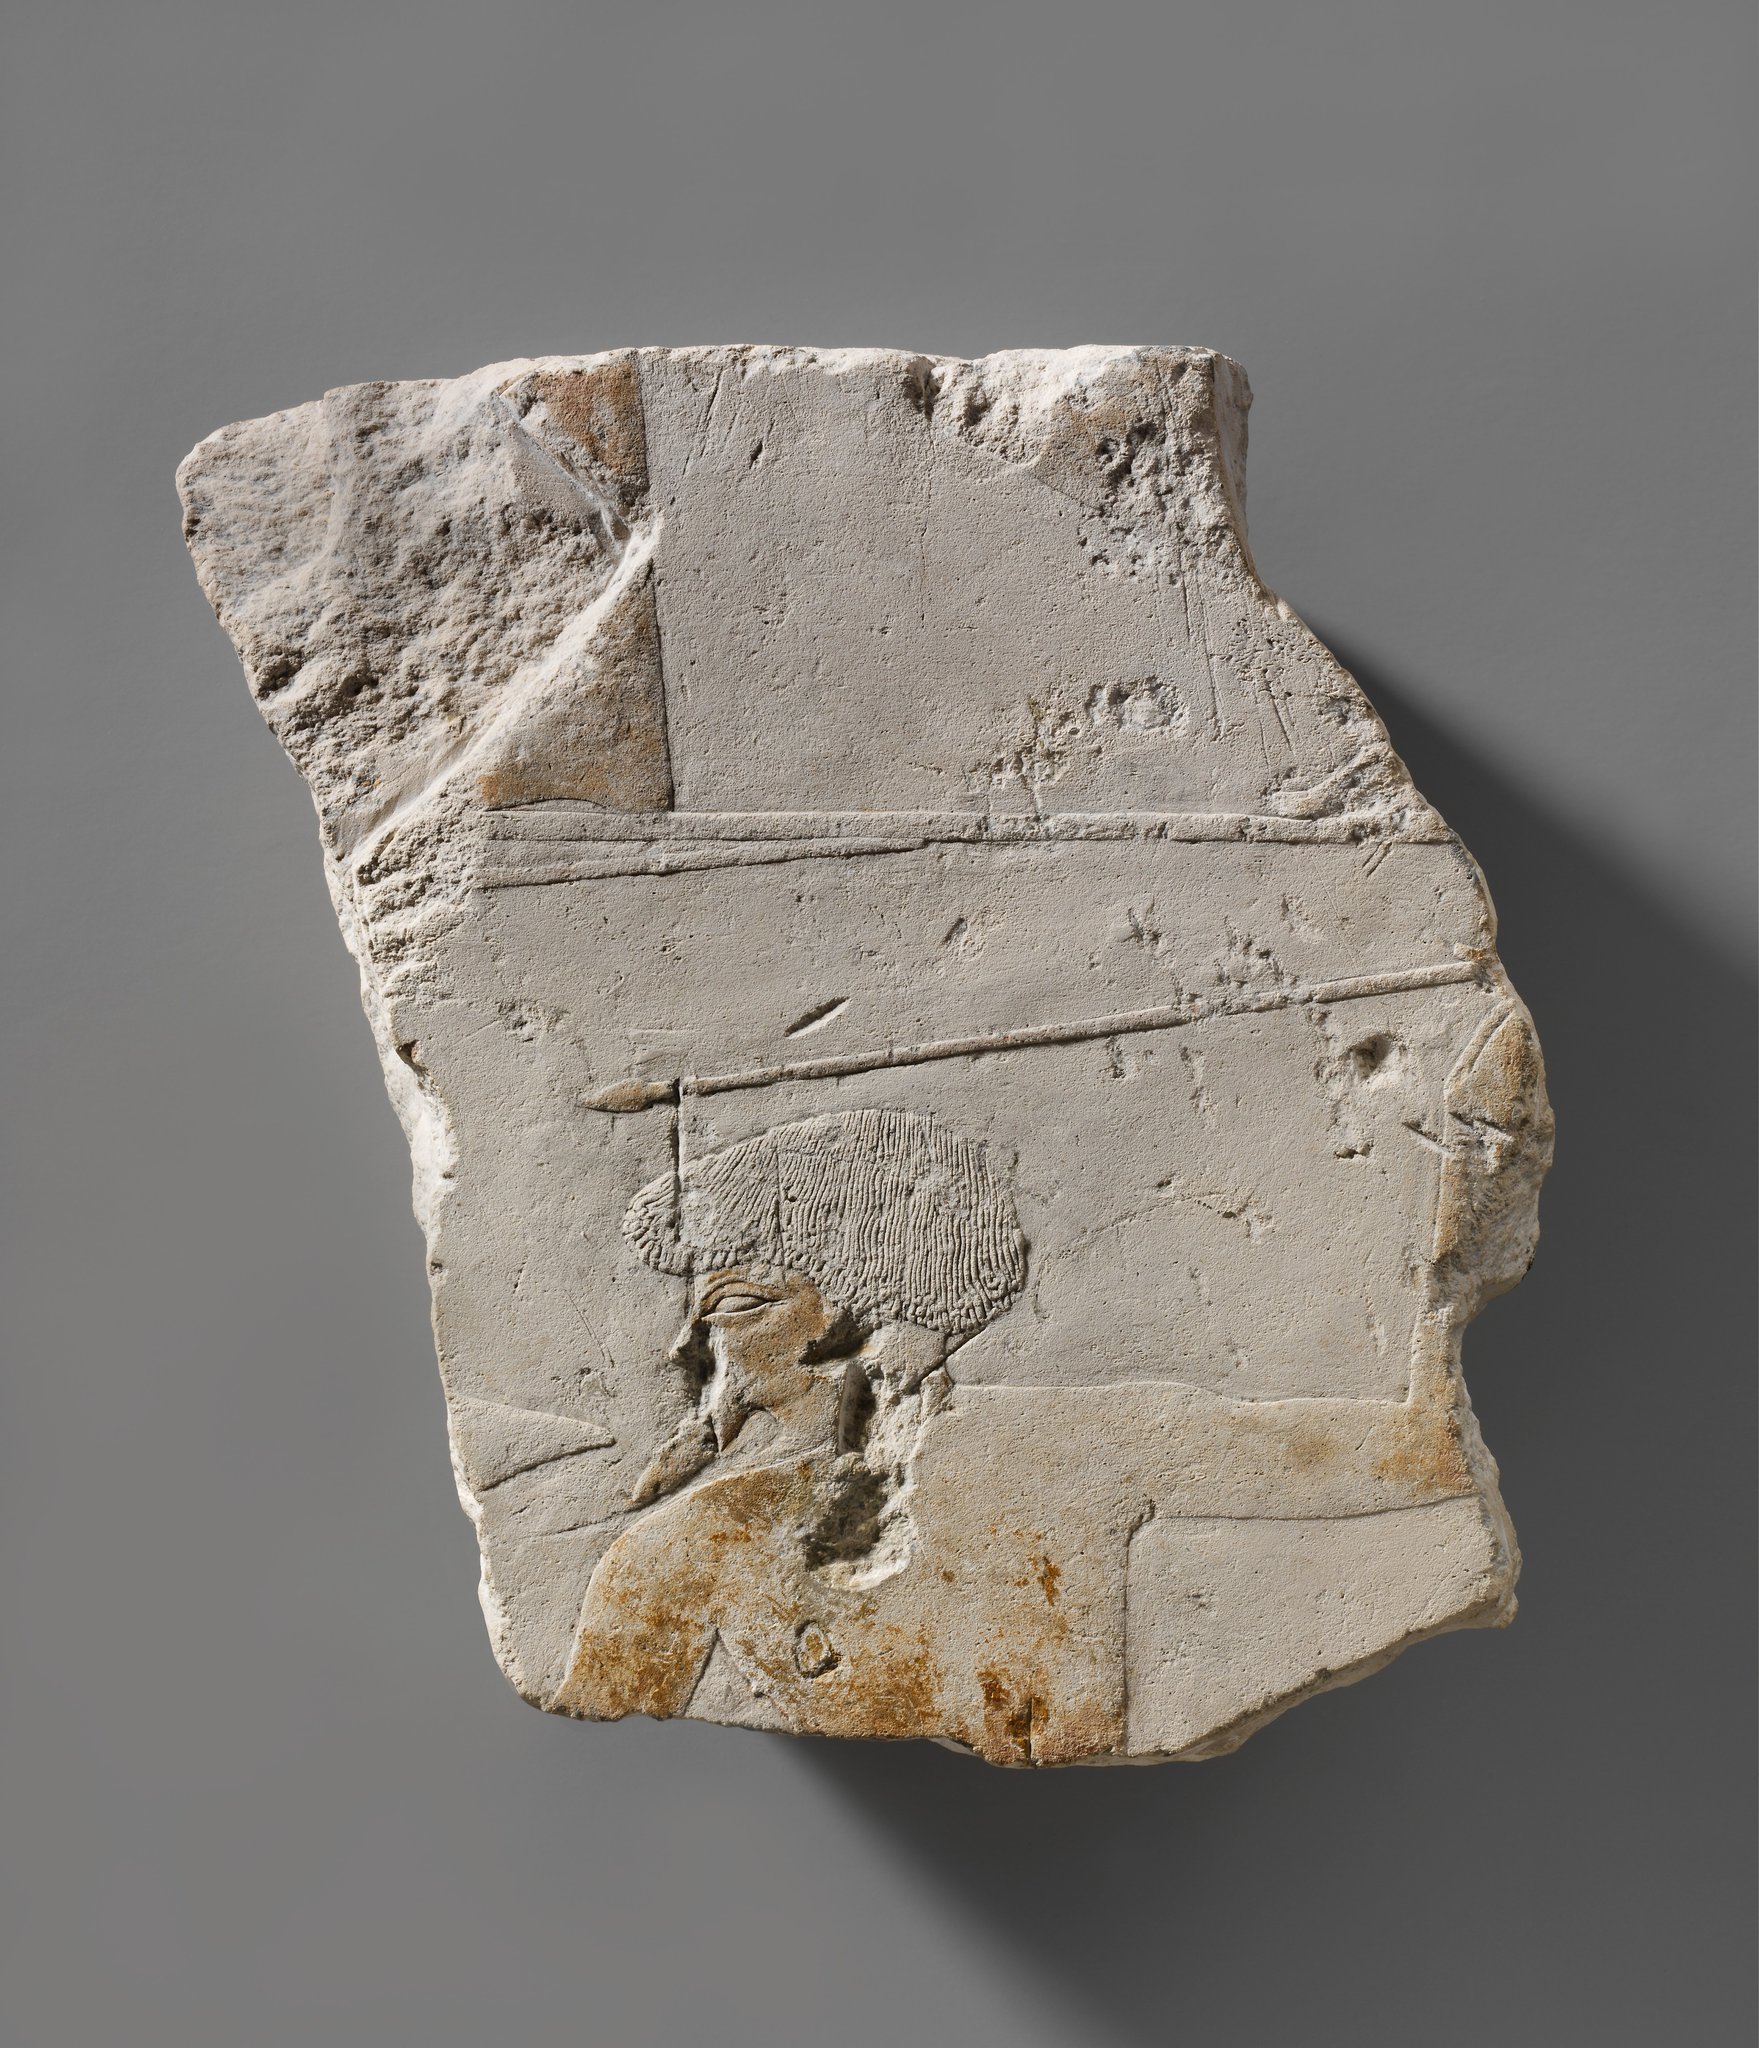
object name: relief, senwosret i, foreigner, spear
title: Fragment from a battle scene depicting a foreigner throwing a spear and holding a distinctive shield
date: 1961-1917 BCE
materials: limestone, paint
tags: spears,men